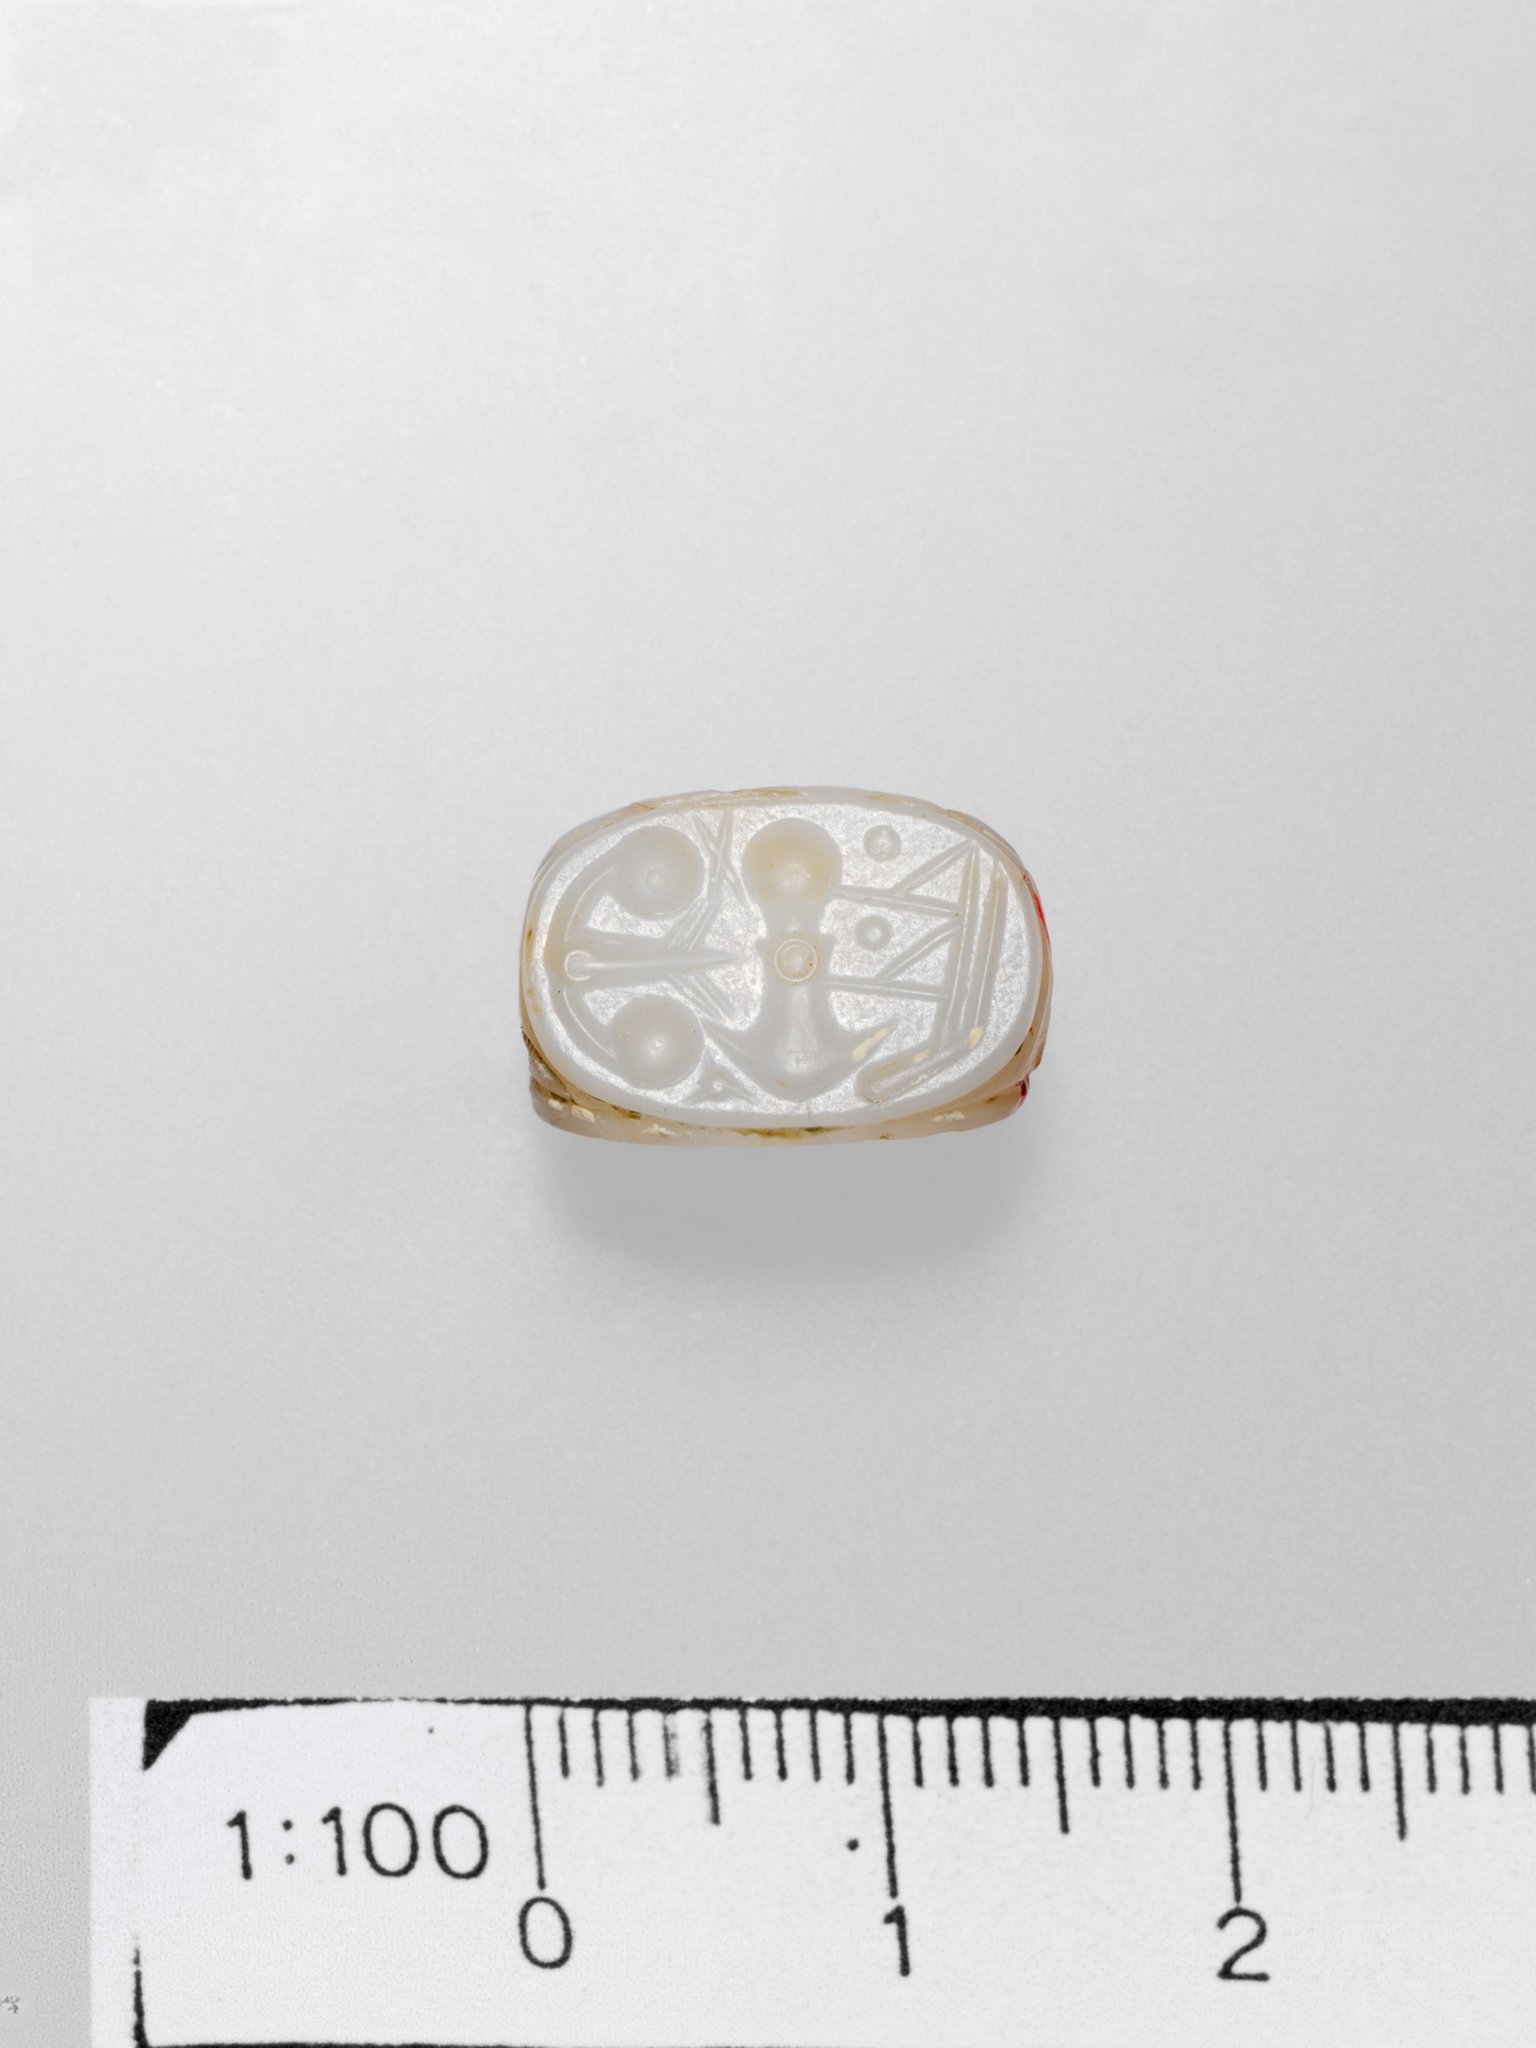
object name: prism, triangular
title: Agate triangular prism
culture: minoan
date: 1900-1600 BCE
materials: stone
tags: hieroglyphs